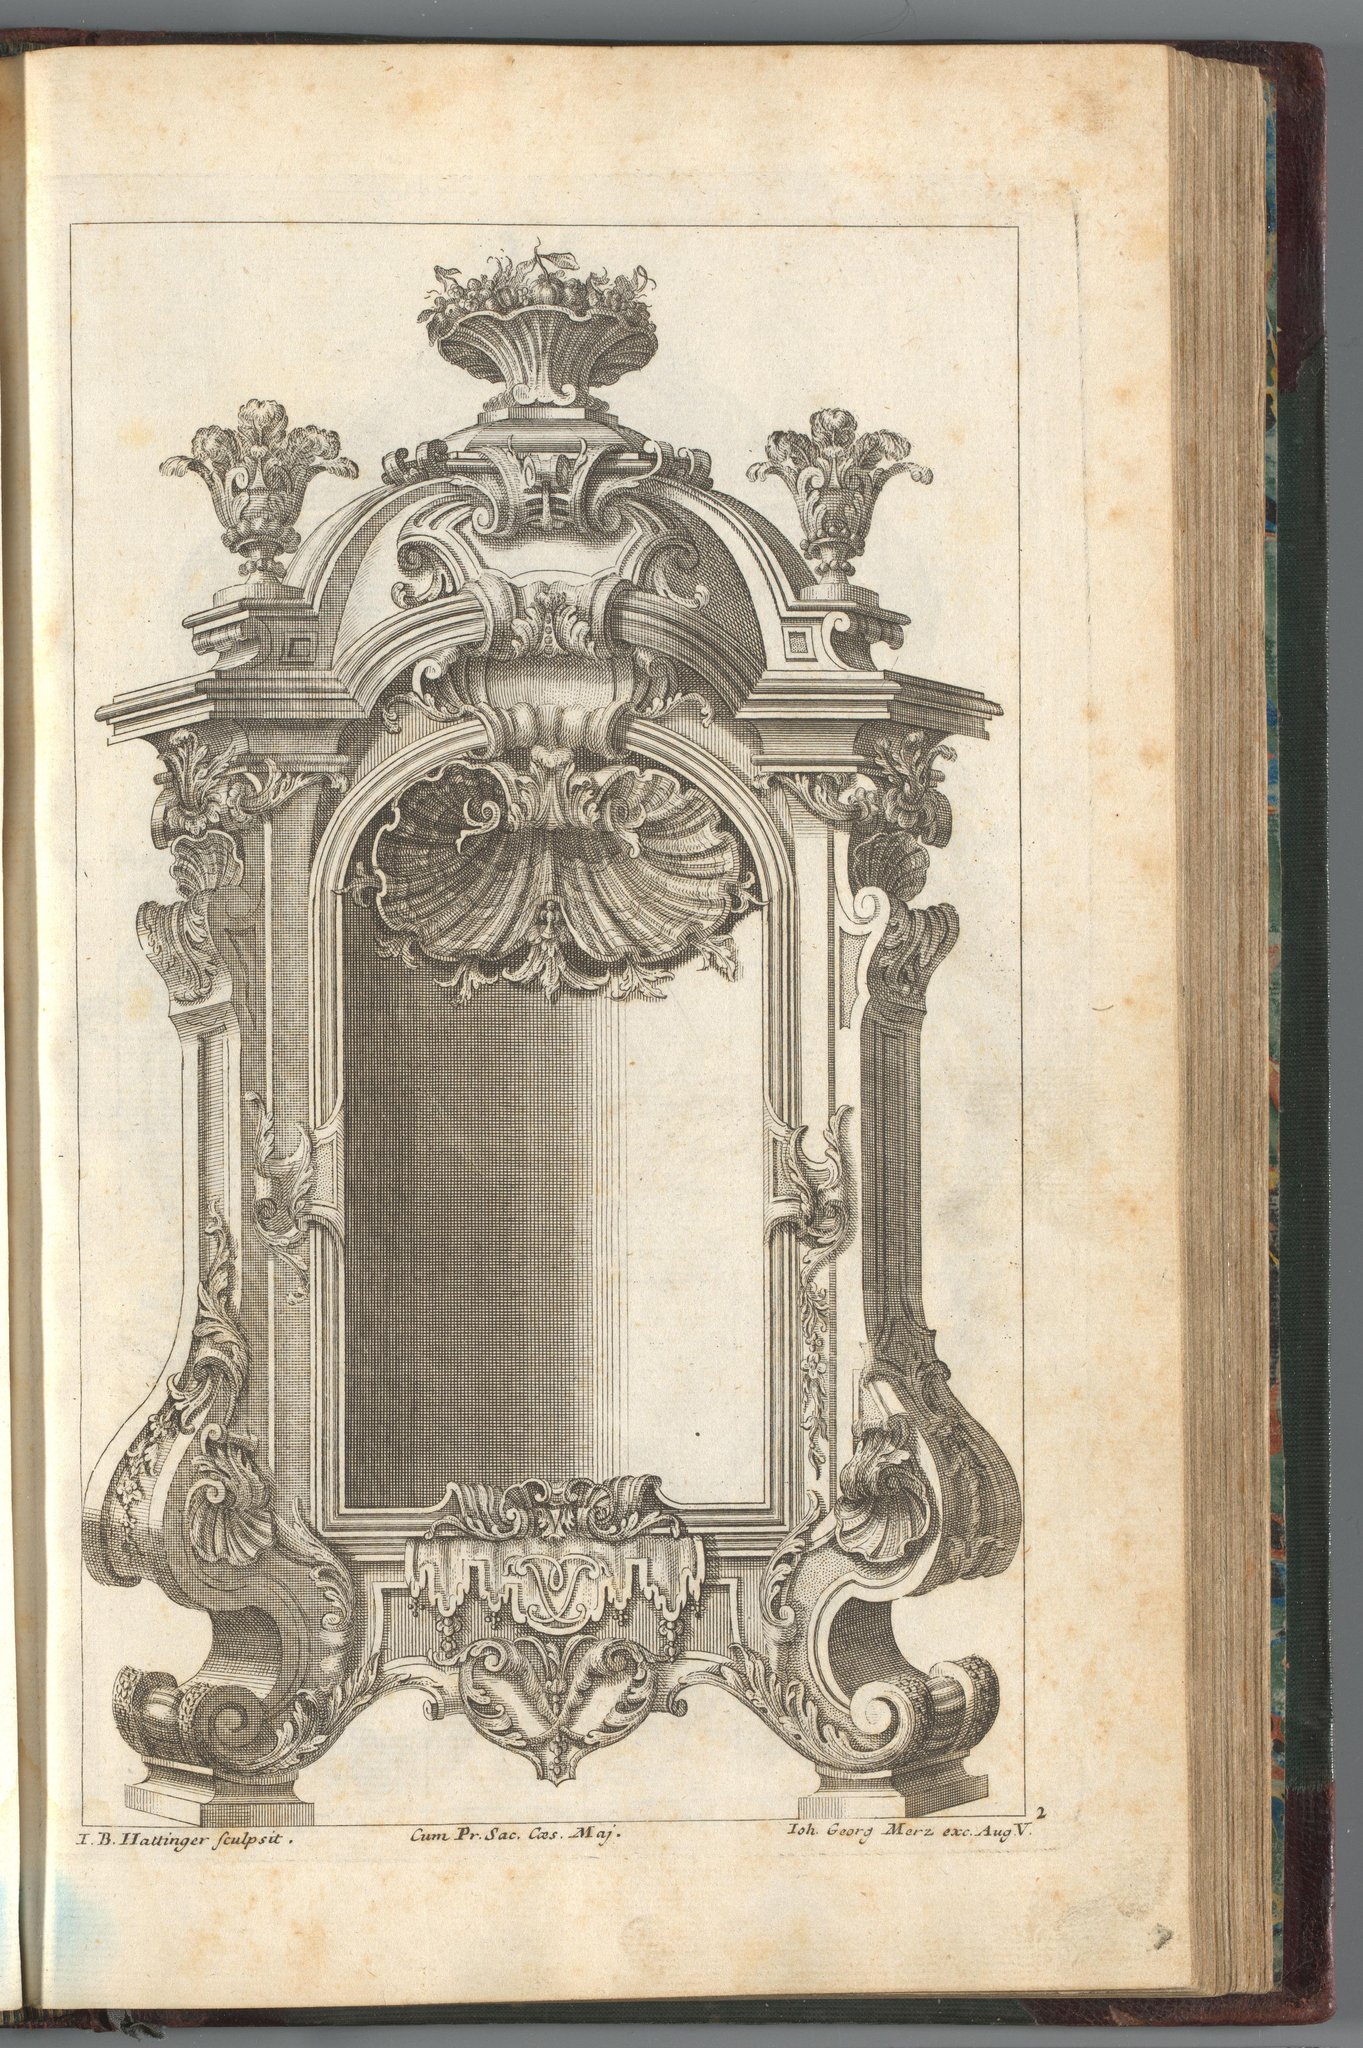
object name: print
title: Altaar ontwerp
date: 1704-1762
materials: paper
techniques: engraving, etching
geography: augsburg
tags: ornaments ~ art, rocaille ornament, altar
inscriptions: signature: ‘Joh Georg Merz exc. Aug V.’, privilege: ‘Cum Pr. Sac. Cas. Maj.’, number: ‘2’, signature: ‘J. B. Hattinger sculpsit’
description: Ontwerp voor een altaar met rocaille ornamenten. Prent maakt deel uit van een album.